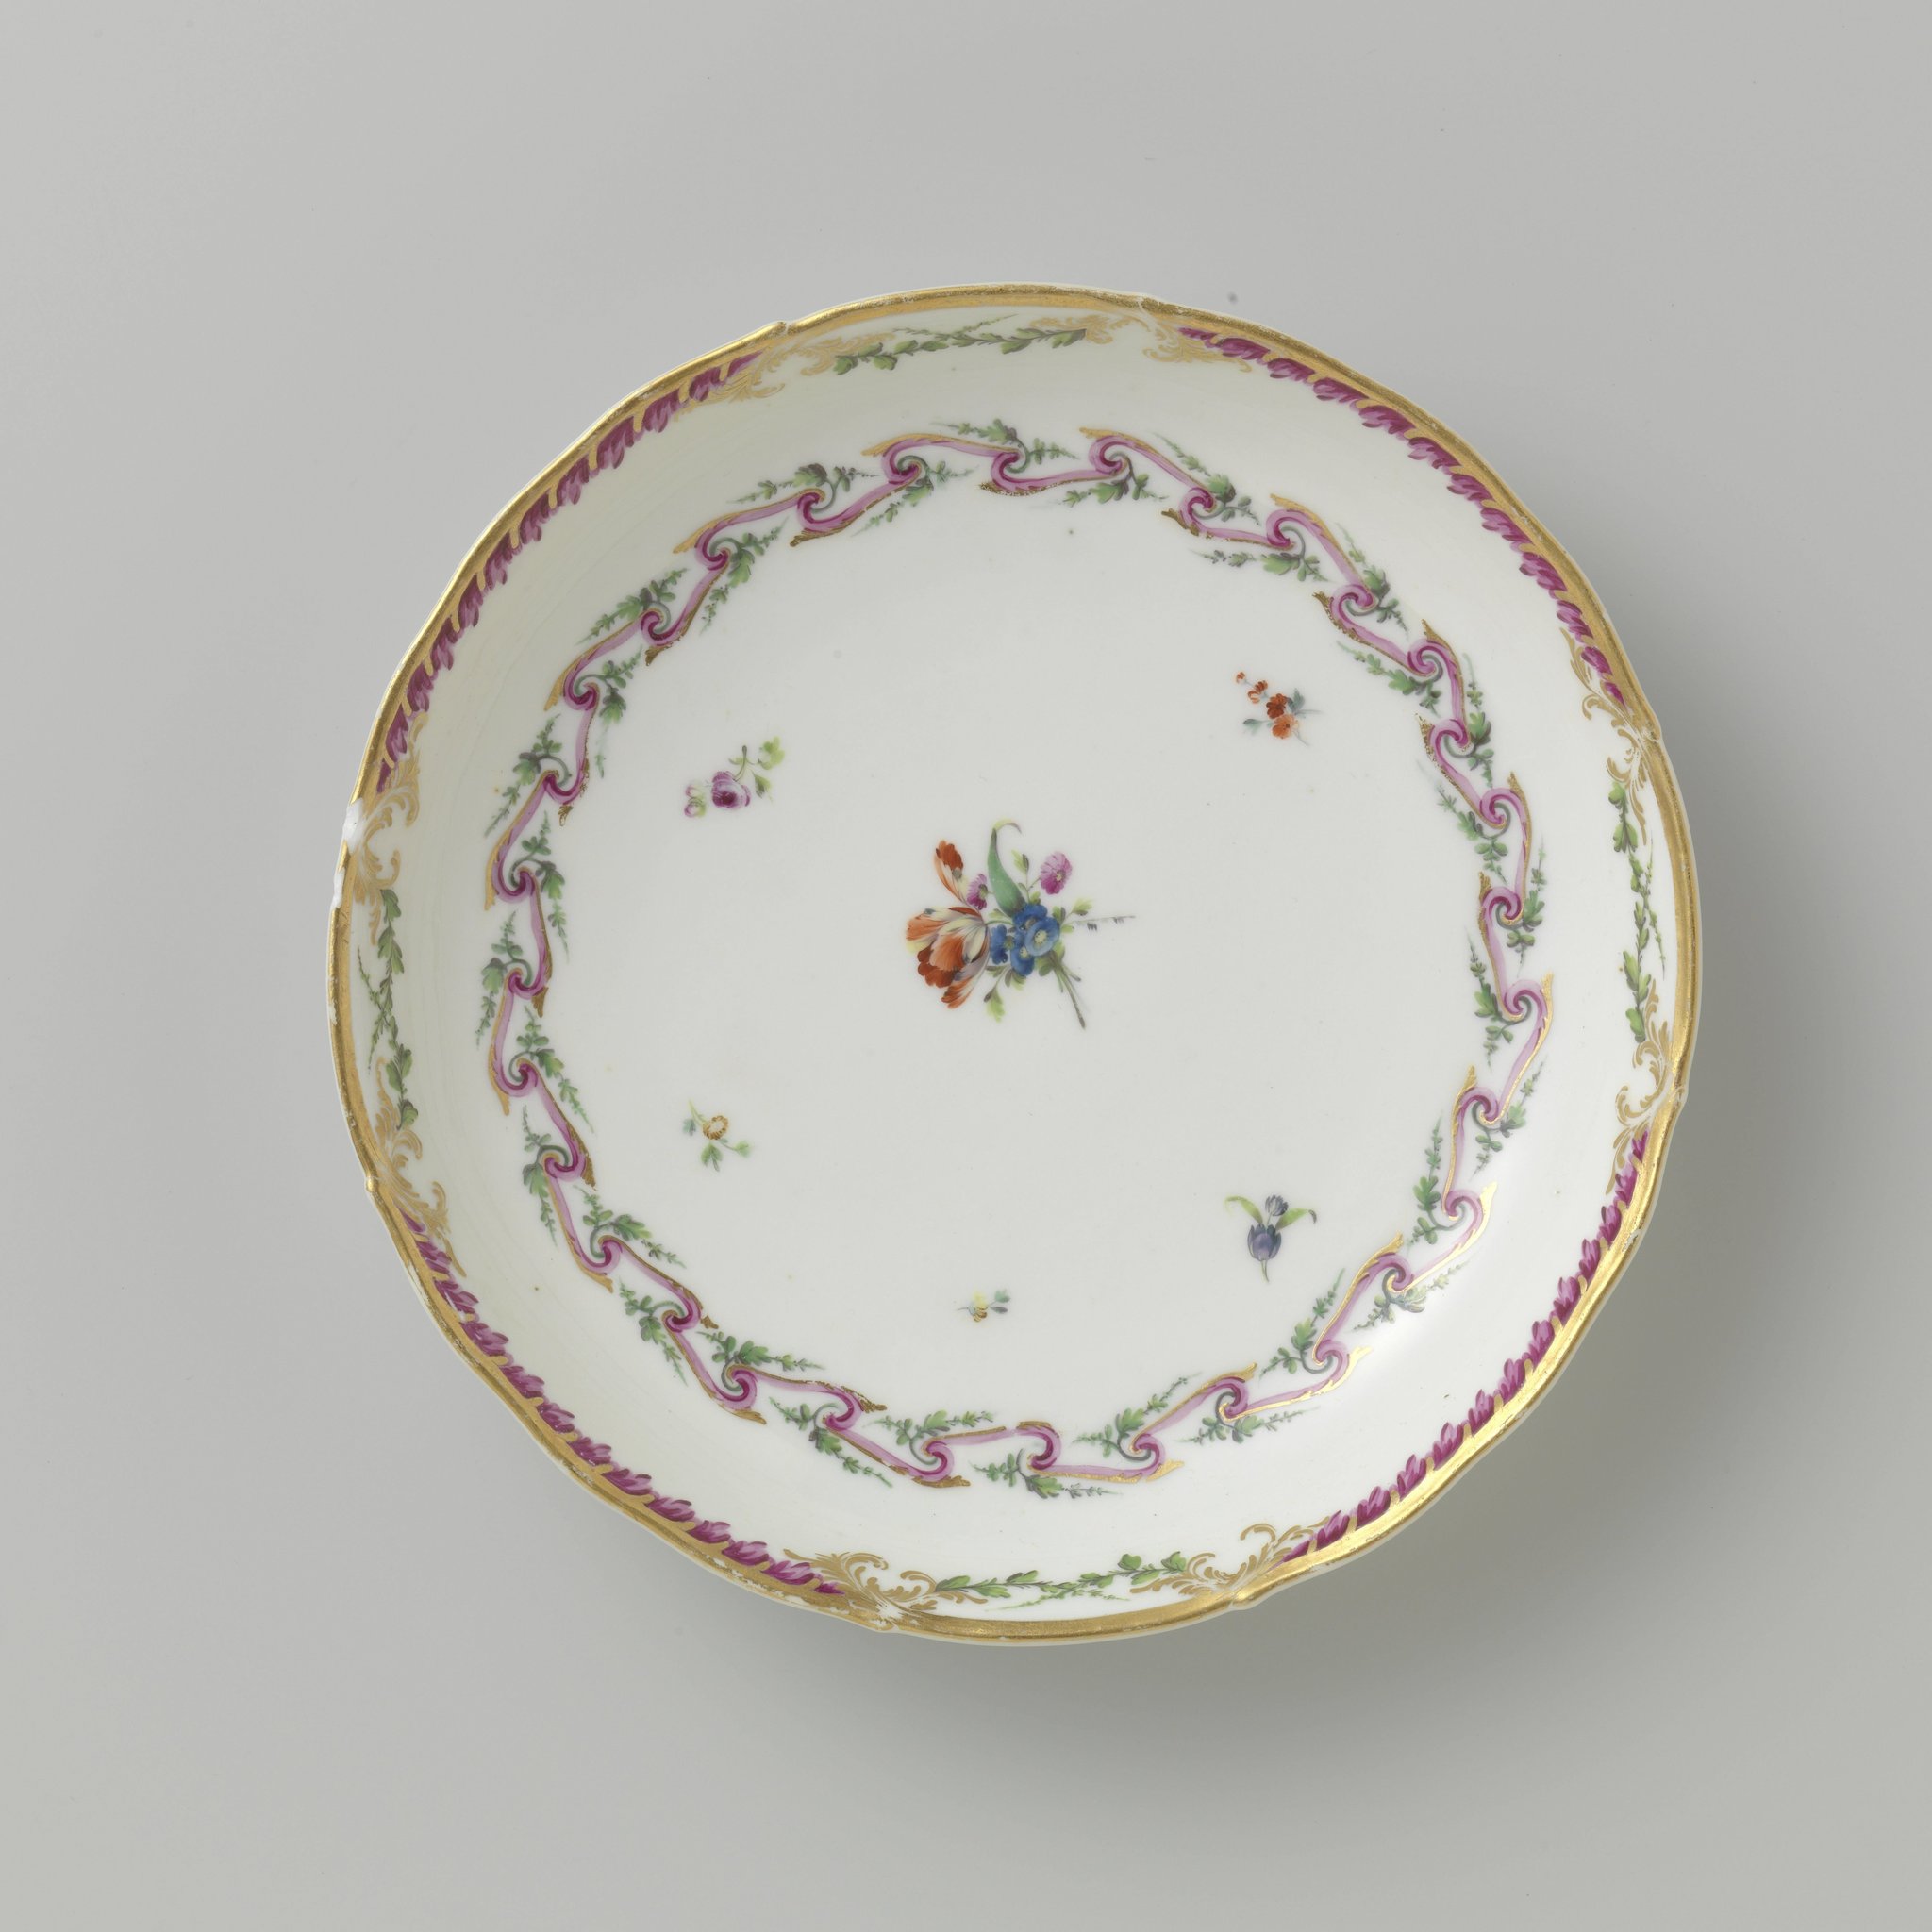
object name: dish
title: Schaal, rond en diep, behorend bij een servies versierd met geslingerd lintmotief met bladertakken, bloemboeketten en gestrooide bloemtakken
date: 1780-1820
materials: porcelain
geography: amsterdam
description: Schaal, rond en diep , behorend bij een servies van porselein versierd met een geslingerd lintmotief in paars en goud met groene bladertakken, bloemboeketten en gestrooide bloemtakken. Randen licht gegolfd, met decoratie in goud met paars bladmotief waartussen groen gekruist bladmotief. Gemerkt: M.O.L. en Amstel.